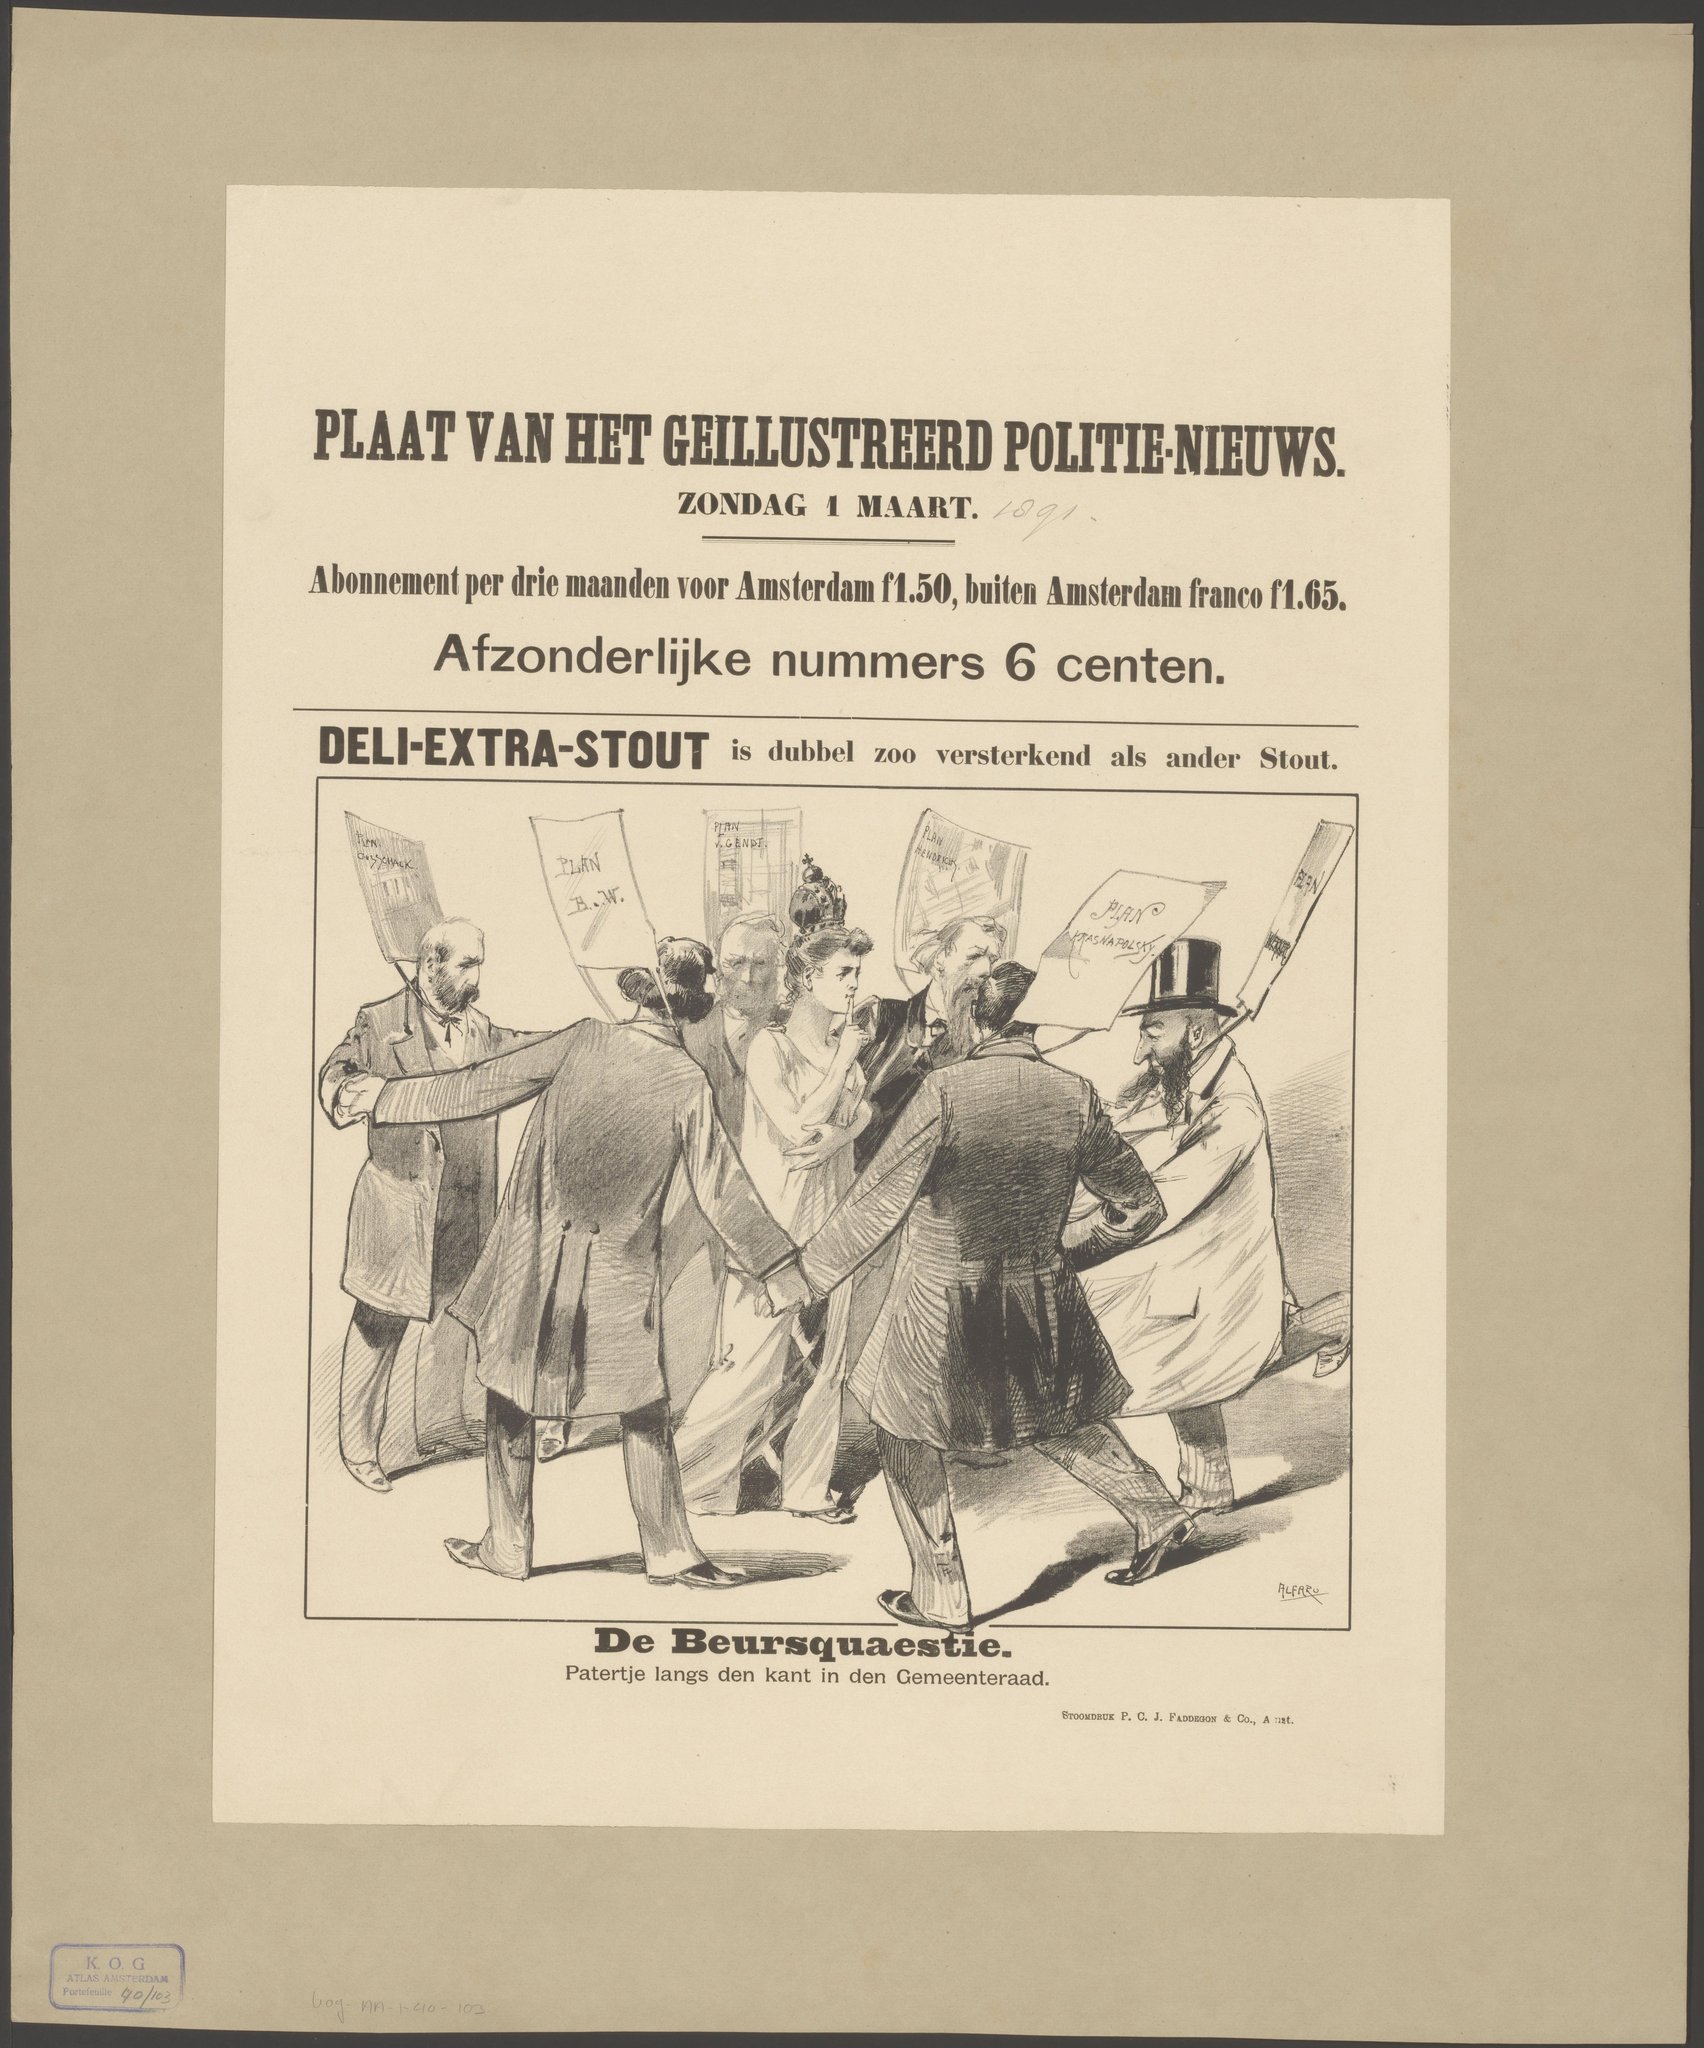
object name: cartoon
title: Amsterdamse stedenmaagd omringd door mannen met plakkaten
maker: alfaro reijding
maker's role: draughtsman, engineer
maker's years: 1863-1930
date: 1891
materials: paper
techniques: letterpress printing, lithograph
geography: amsterdam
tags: personification of a city, town-patron(ess), group dancing around someone or something (folk dancing), political caricatures and satires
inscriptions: collector's mark: Lugt 1641b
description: Onderwerpsrubriek binnen de Atlas Amsterdam: Handel en Zeevaart: Hulpbeurs op de Dam en Beurs (Dam).